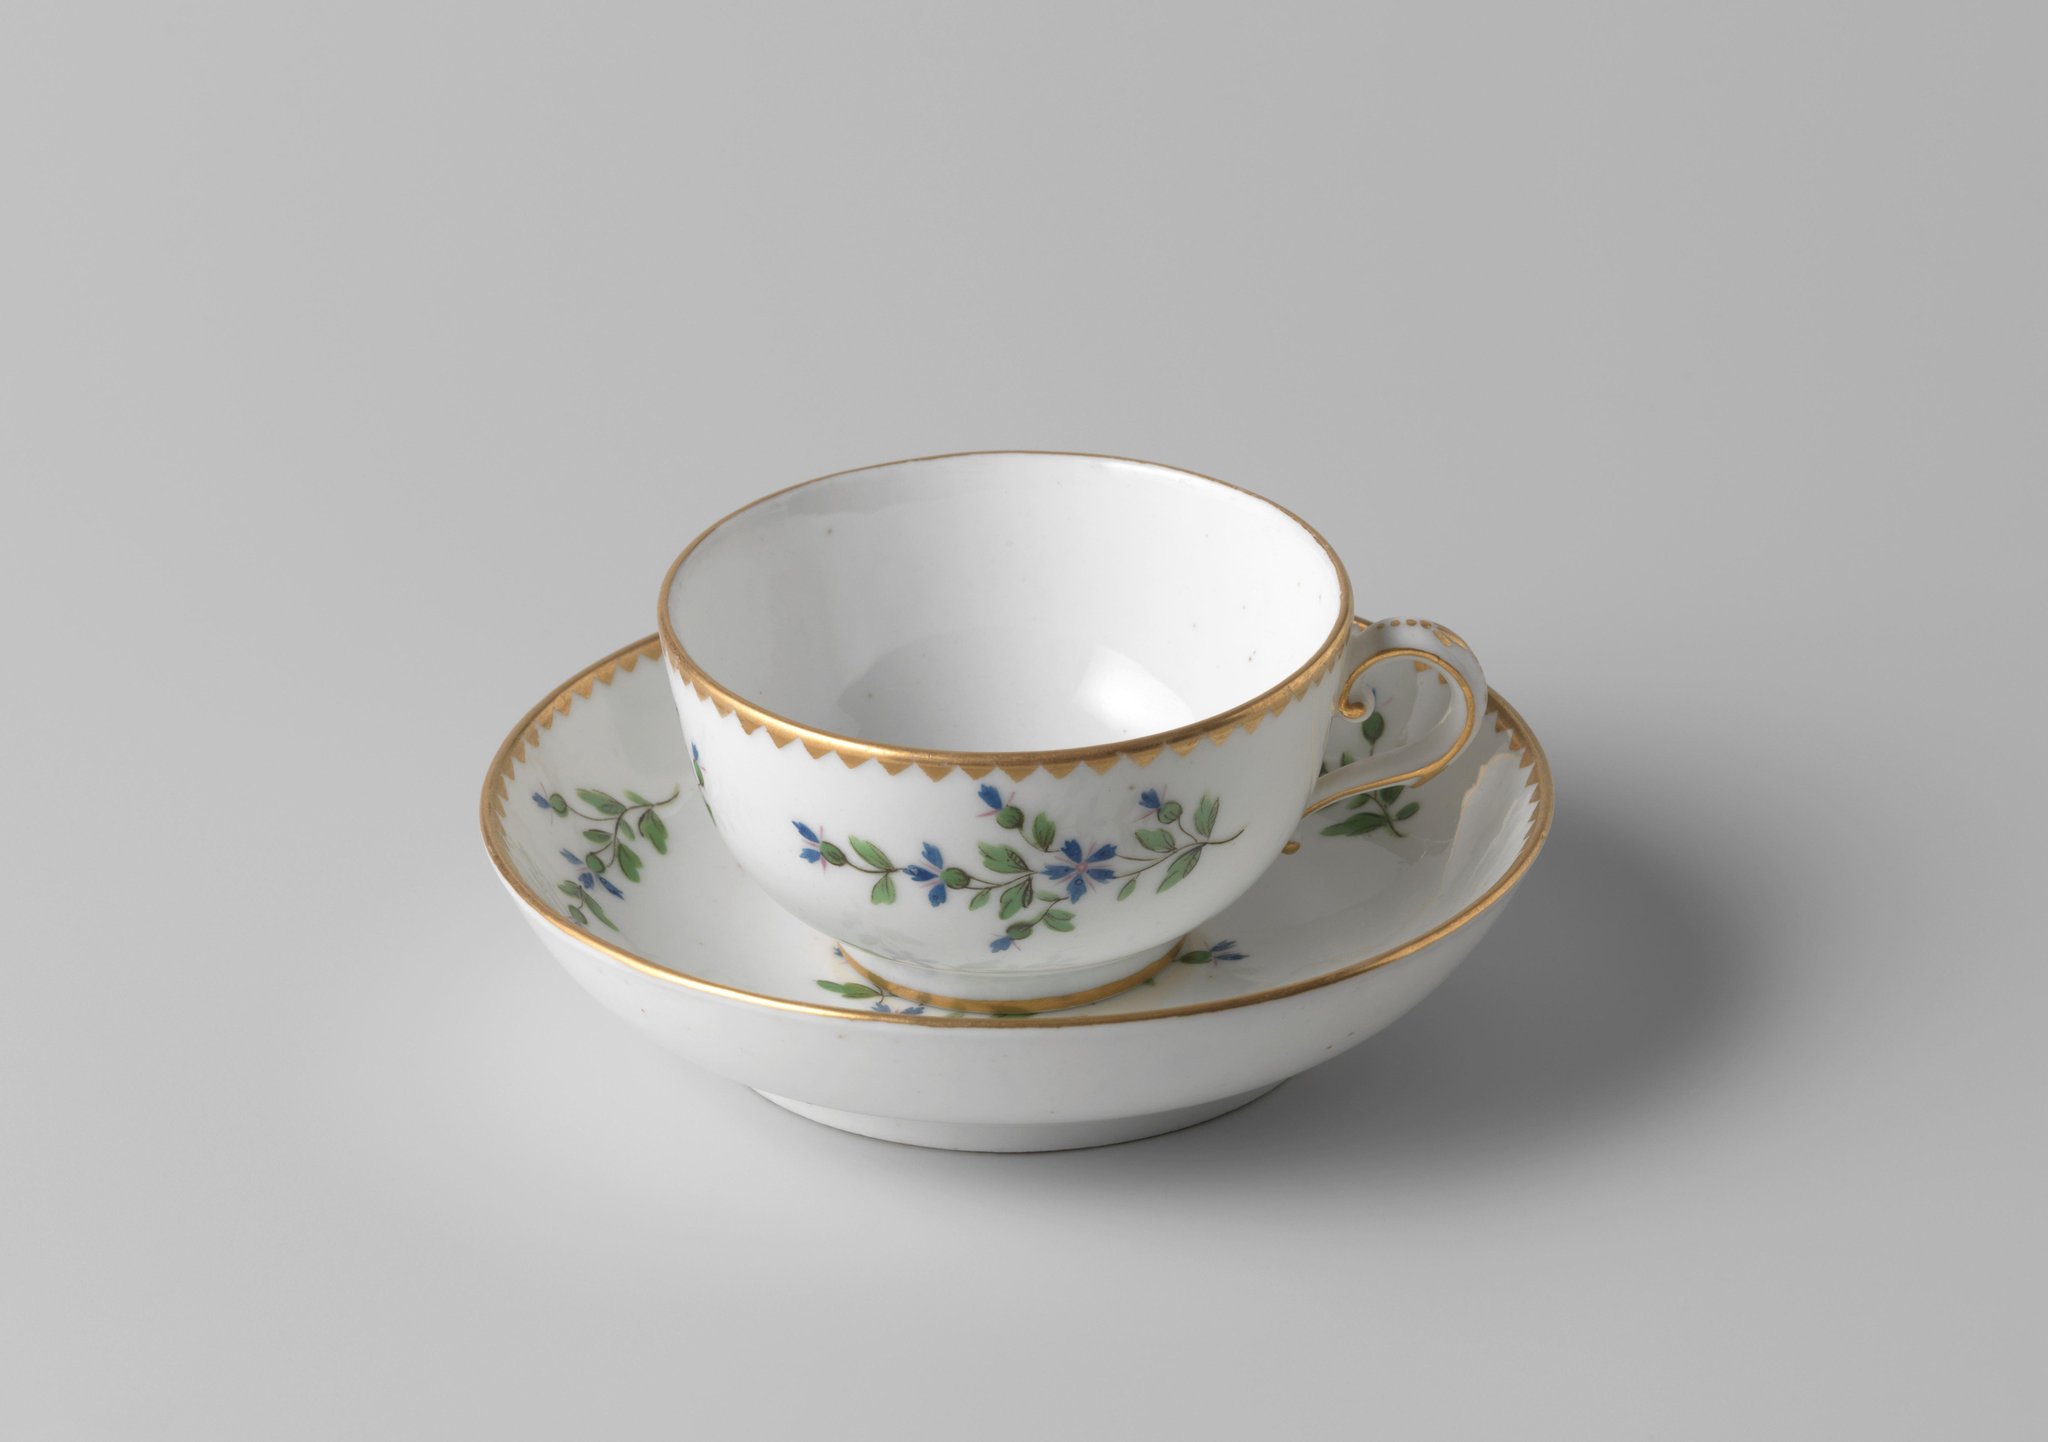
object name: platter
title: Saucer with flower sprays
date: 1790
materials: glaze, gold, paint, porcelain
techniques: firing, forming, gilding, turning, vitrification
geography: lille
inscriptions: mark: ‘gekroonde dolfijn’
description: Schotel van porselein, beschilderd op het glazuur in blauw, roze, groen, zwart en goud. Op het plat een bloemtak (korenbloem) omgeven door drie dezelfde bloemtakken op de wand. Een band met gouden driehoeken op de rand. Gemerkt op de onderzijde met de gekroonde dolfijn.